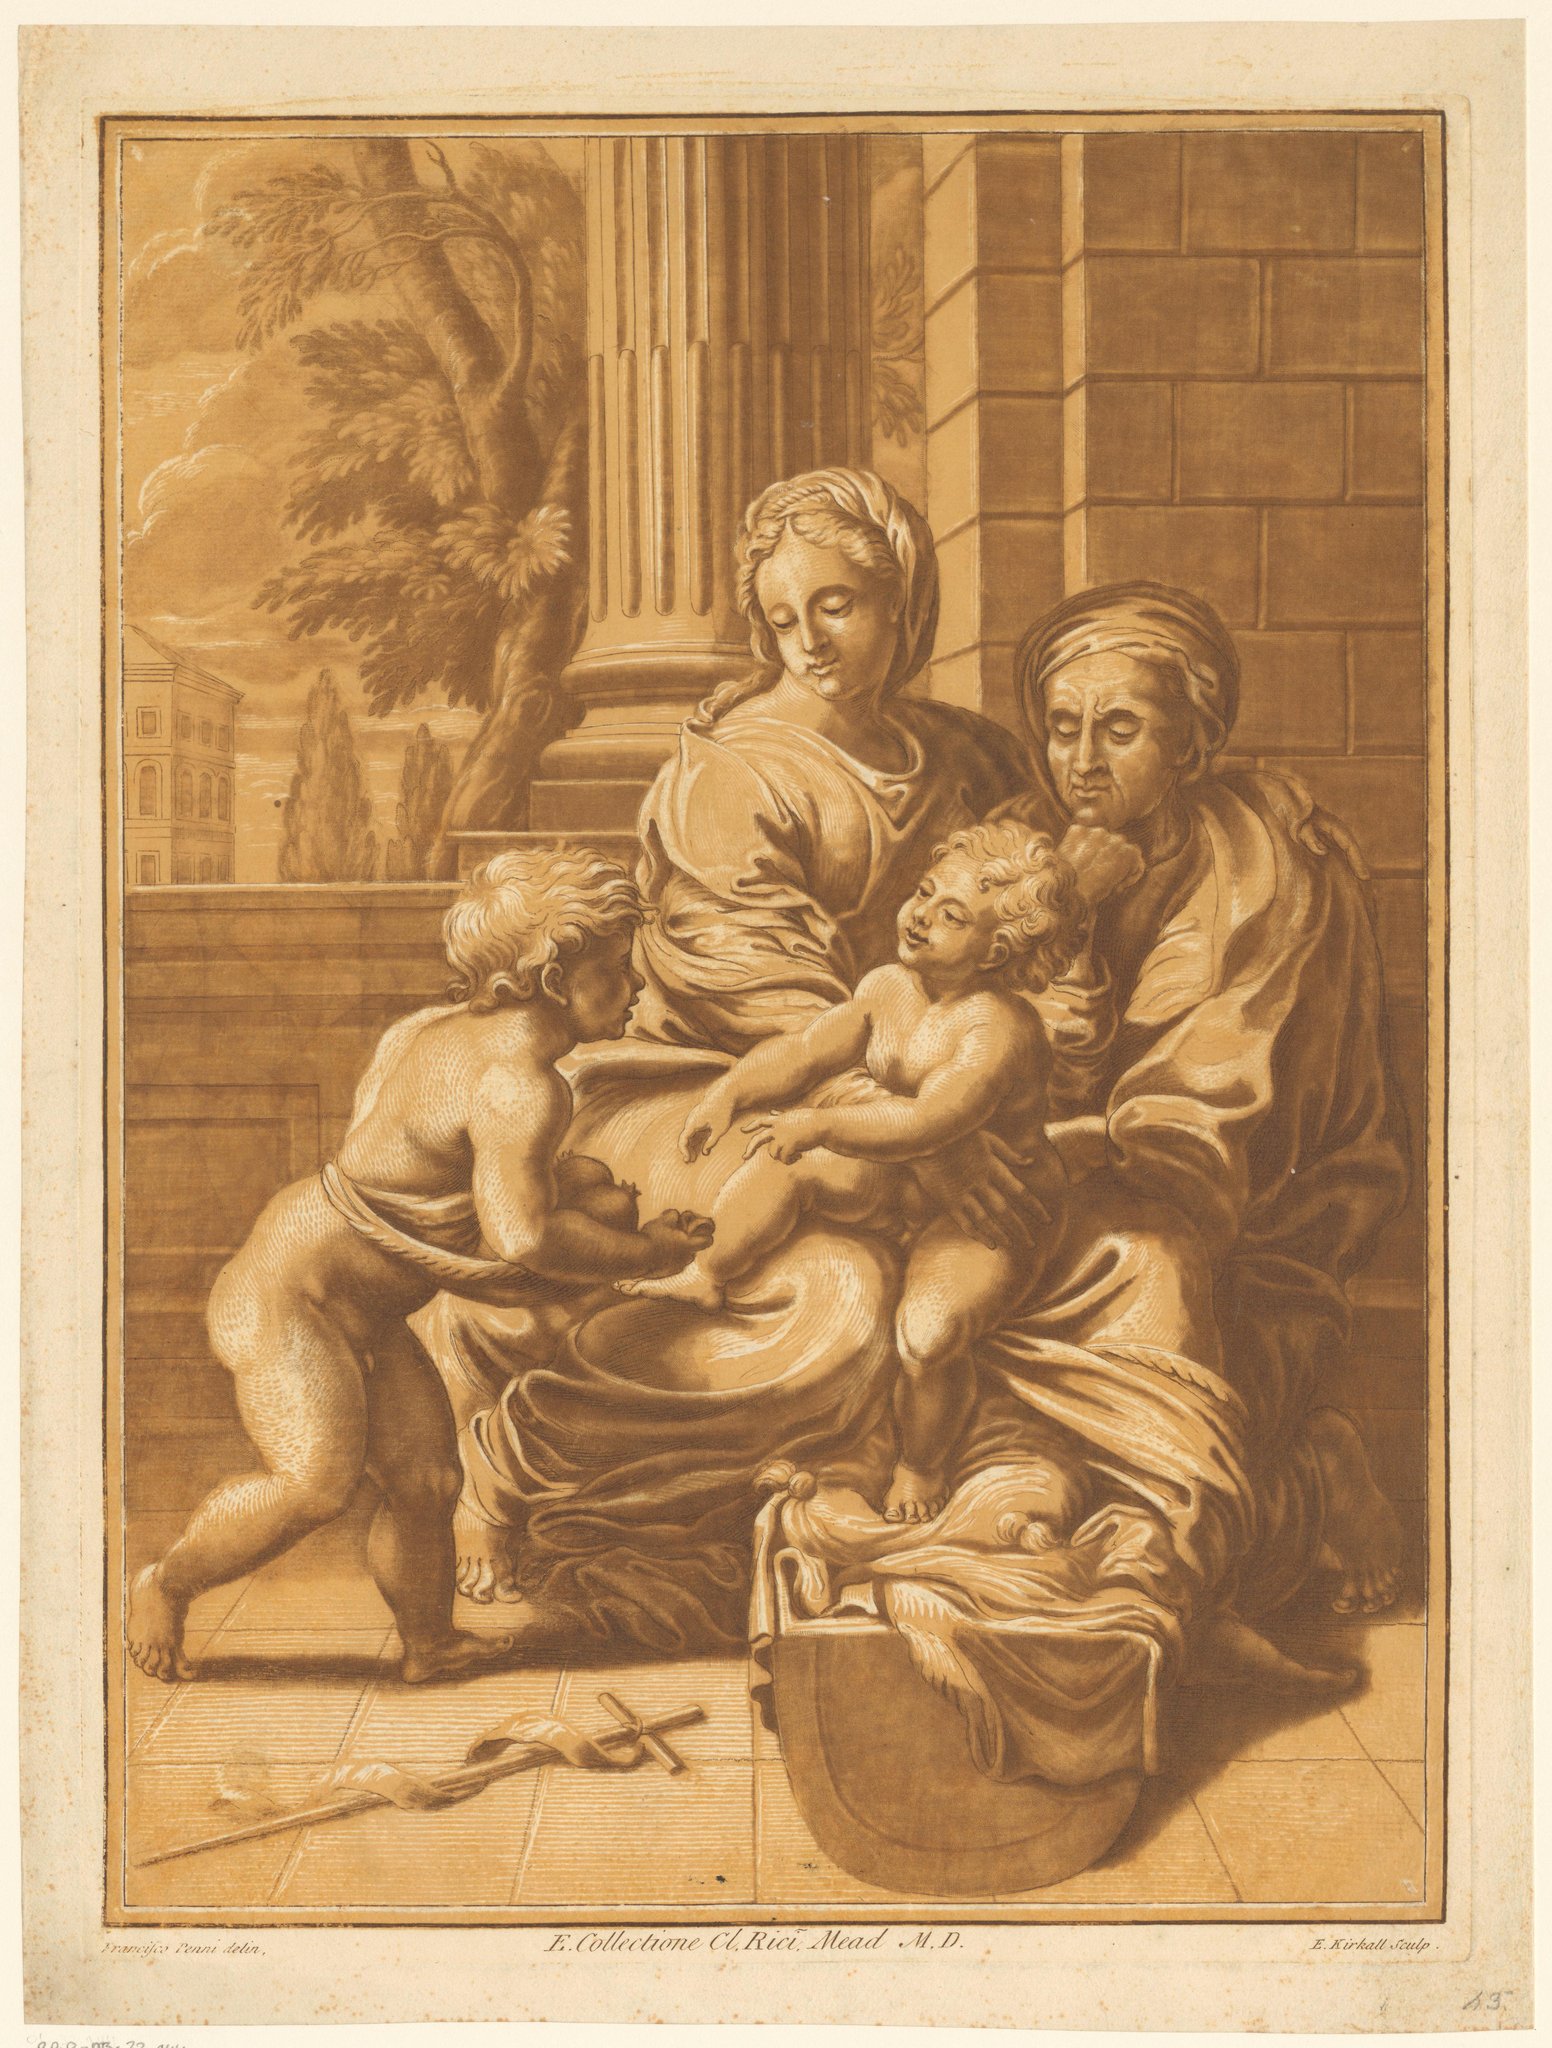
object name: print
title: E. Collectione cl Rici Mead M.D.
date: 1692-1742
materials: paper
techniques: woodcut, etching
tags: mary, the christ-child and john the baptist, elisabeth present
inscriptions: collector's mark: Lugt 240